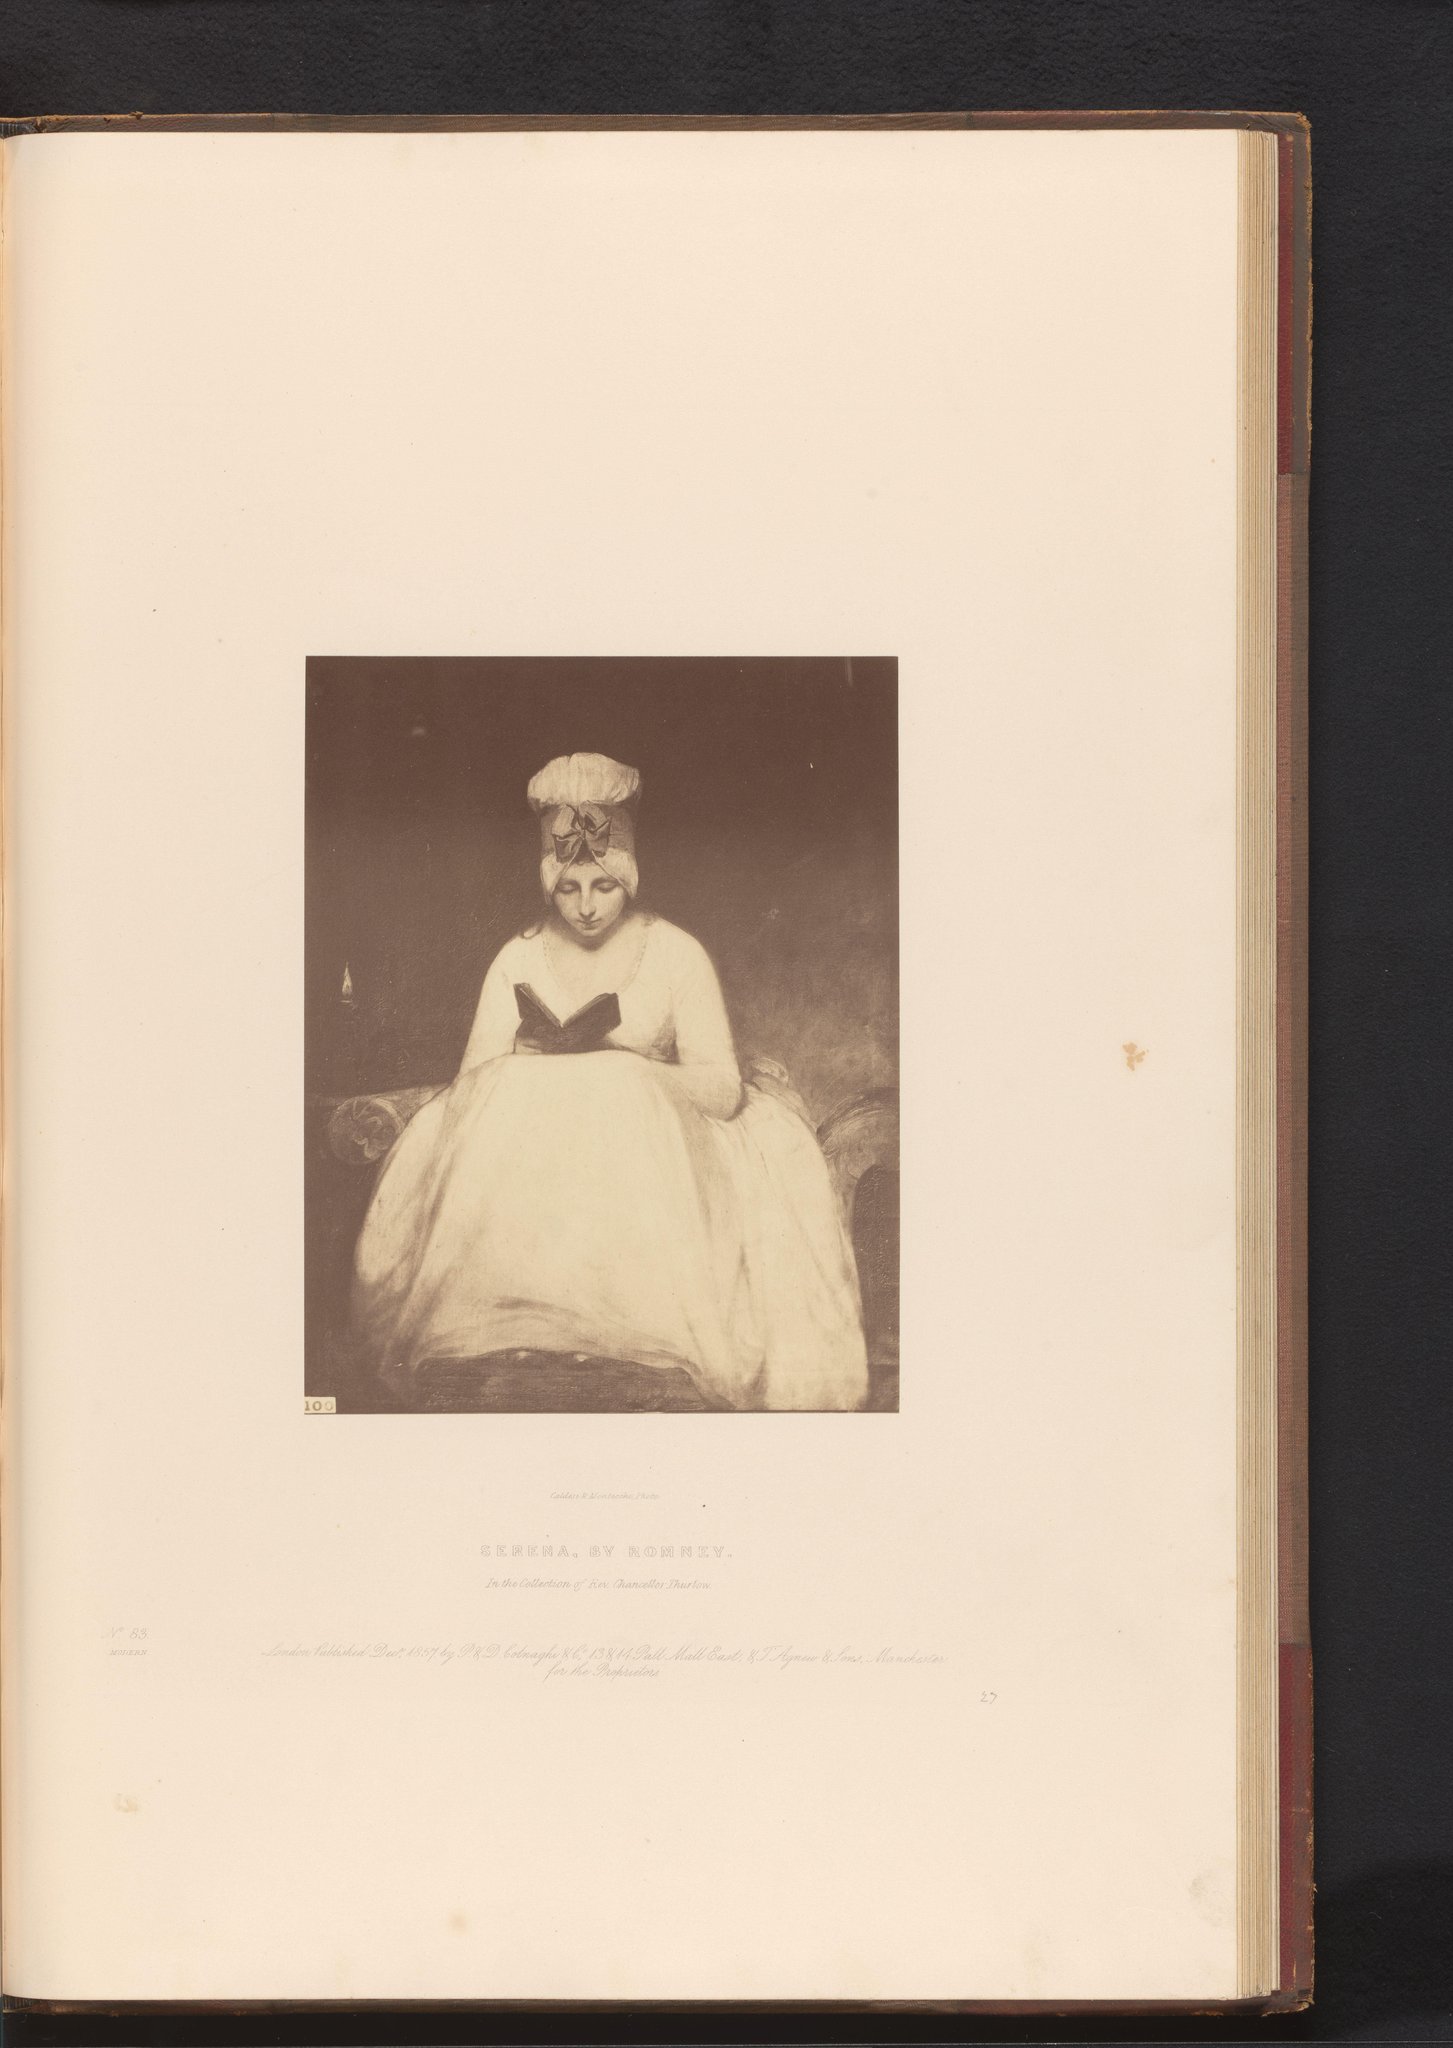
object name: photograph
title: Fotoreproductie van een schilderij van een portret van een lezende vrouw genaamd Serena, door George Romney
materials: photographic support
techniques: albumen print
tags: reading, historical persons not known by name - bb - woman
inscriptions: number: ‘No. 83./ MODERN.’, number: ‘27’, inscription: ‘In the Collection of Rev. Chancellor Thurlow./ London, Published Decr, 1857, by P. & D. Colnaghi & Co, 13 & 14, Pall Mall East & T. Agneur & Sons, Manchester./ For the Proprietors.’